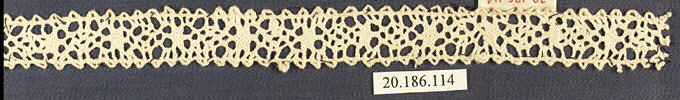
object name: insertion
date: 1601-1700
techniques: lace